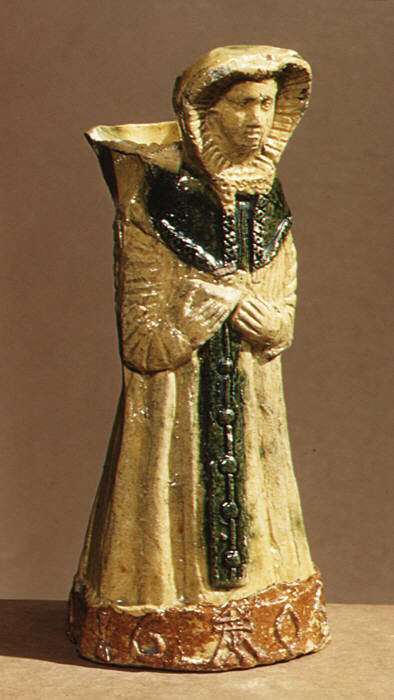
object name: beaker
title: Beaker (one of a pair)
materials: earthenware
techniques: glazing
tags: women